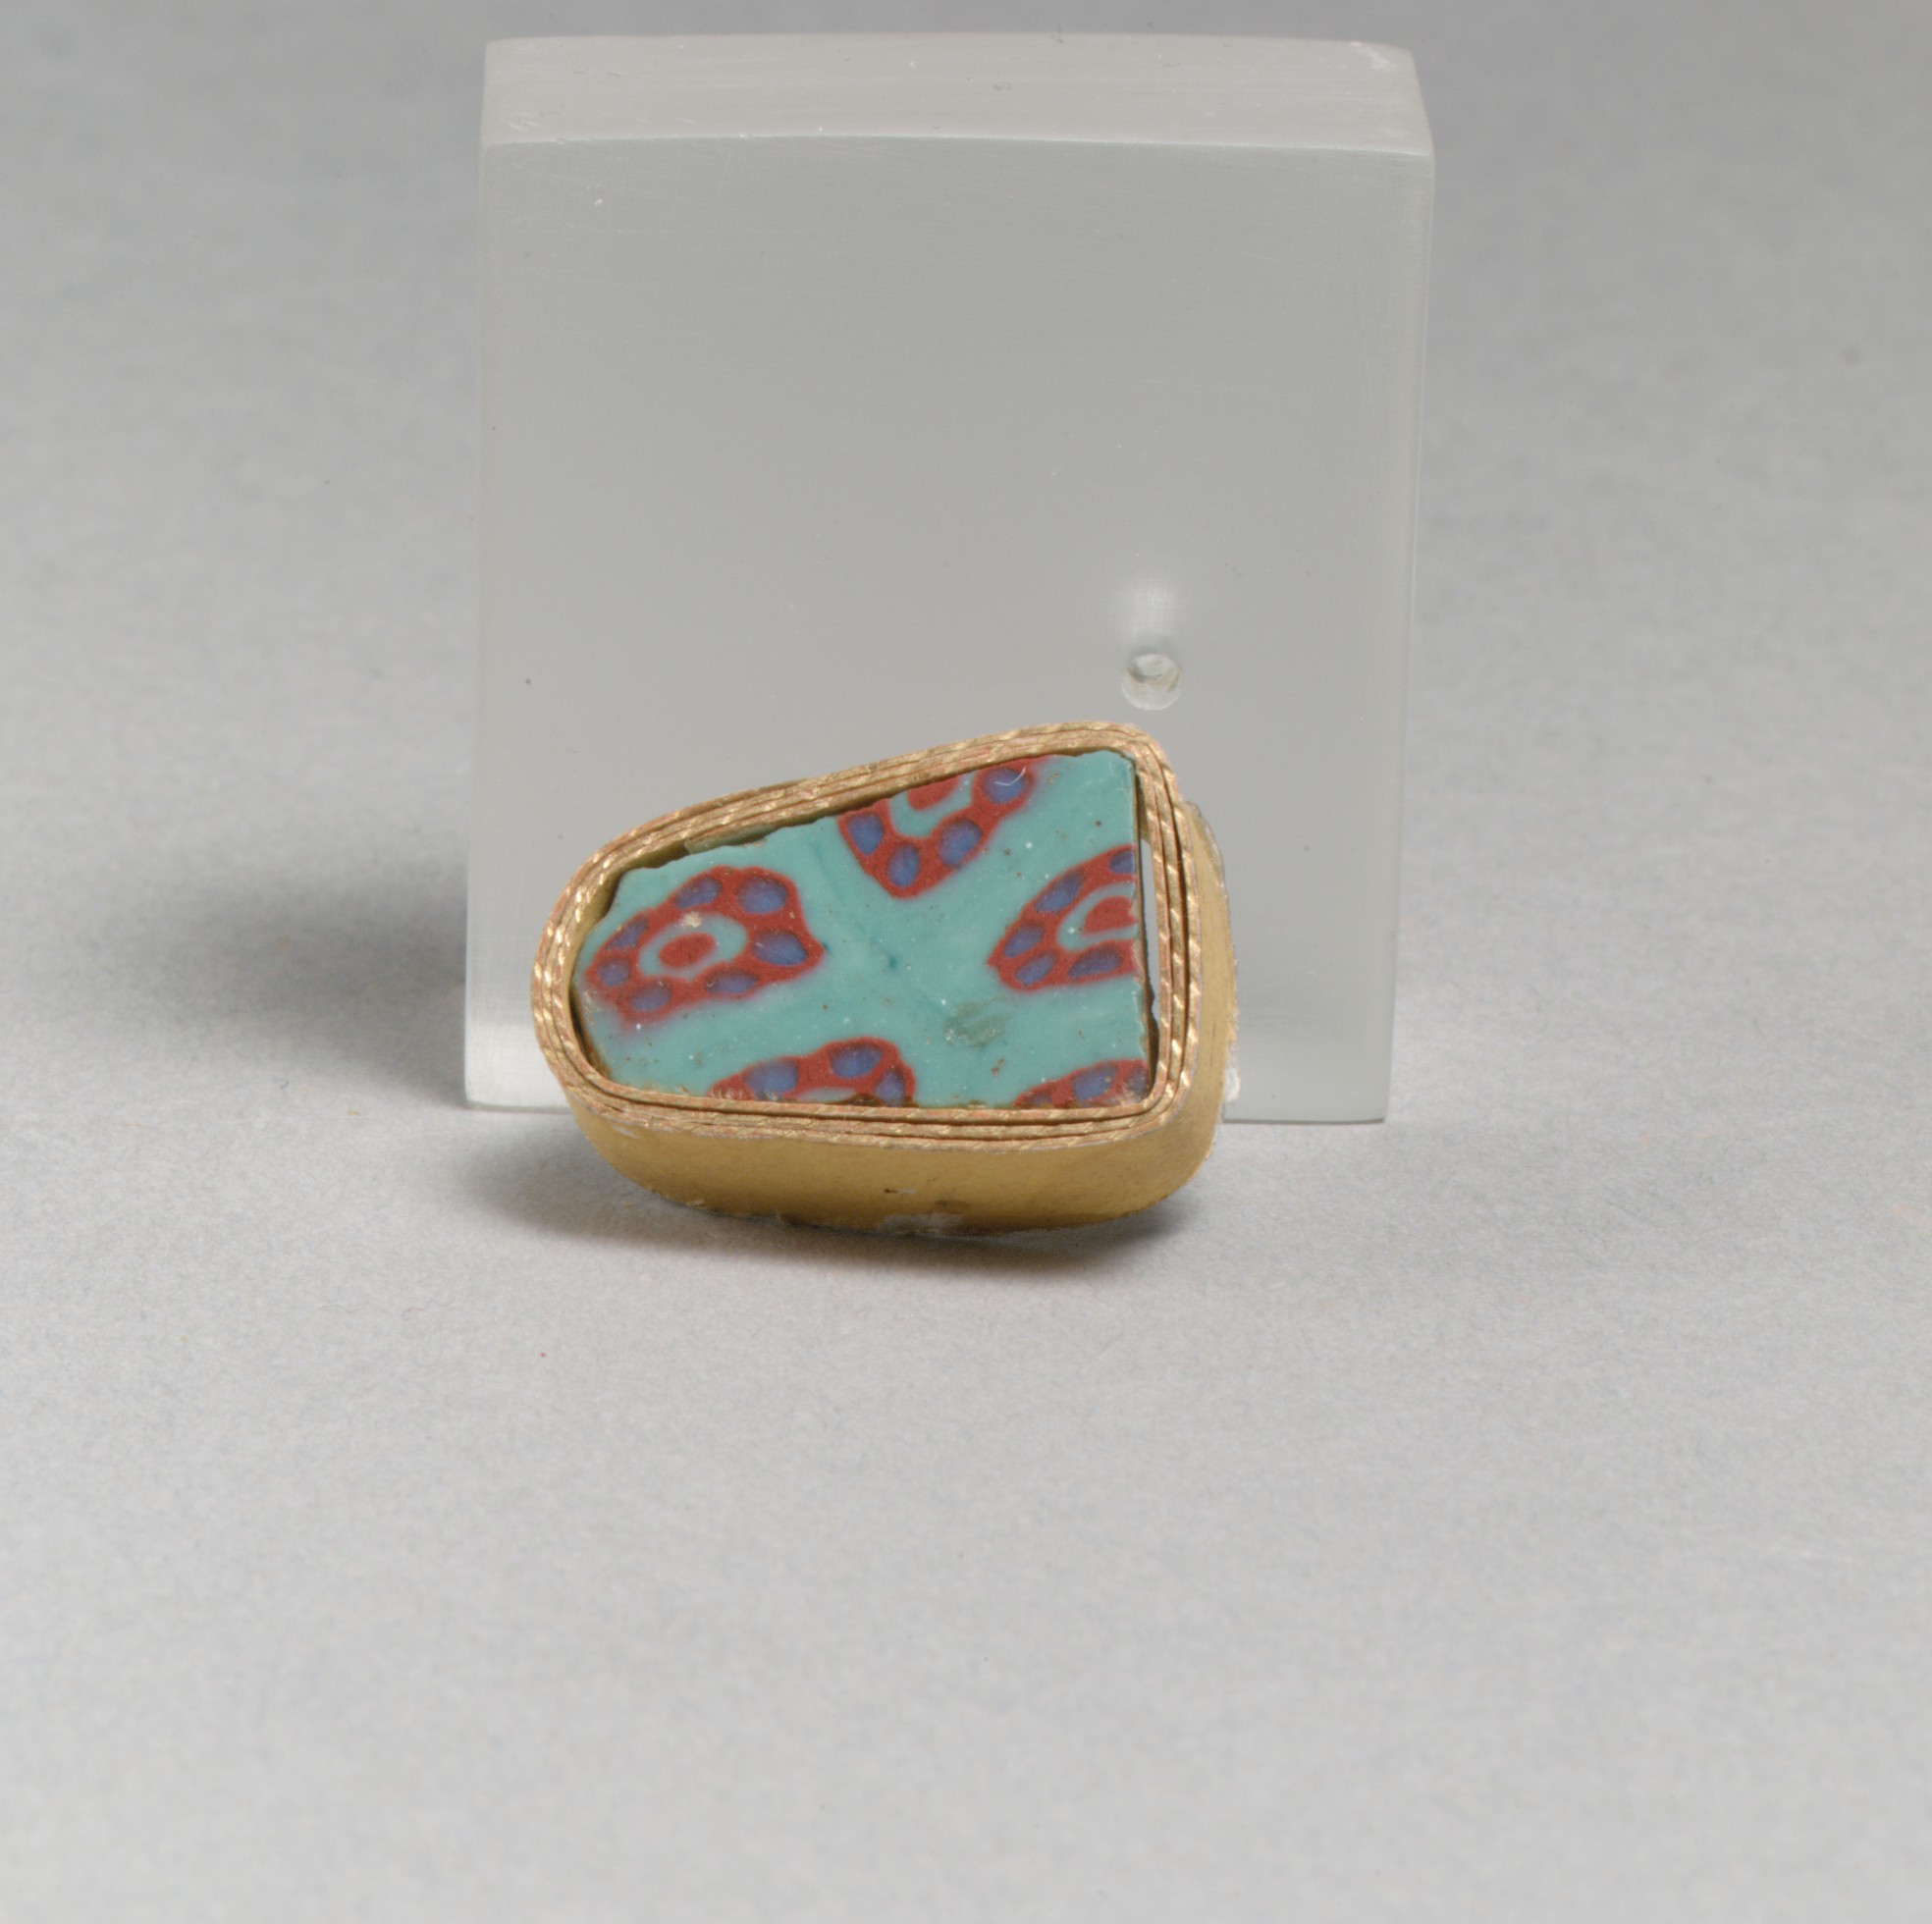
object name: fragment, mosaic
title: Glass mosaic fragment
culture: roman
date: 34 BCE-33 CE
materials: glass